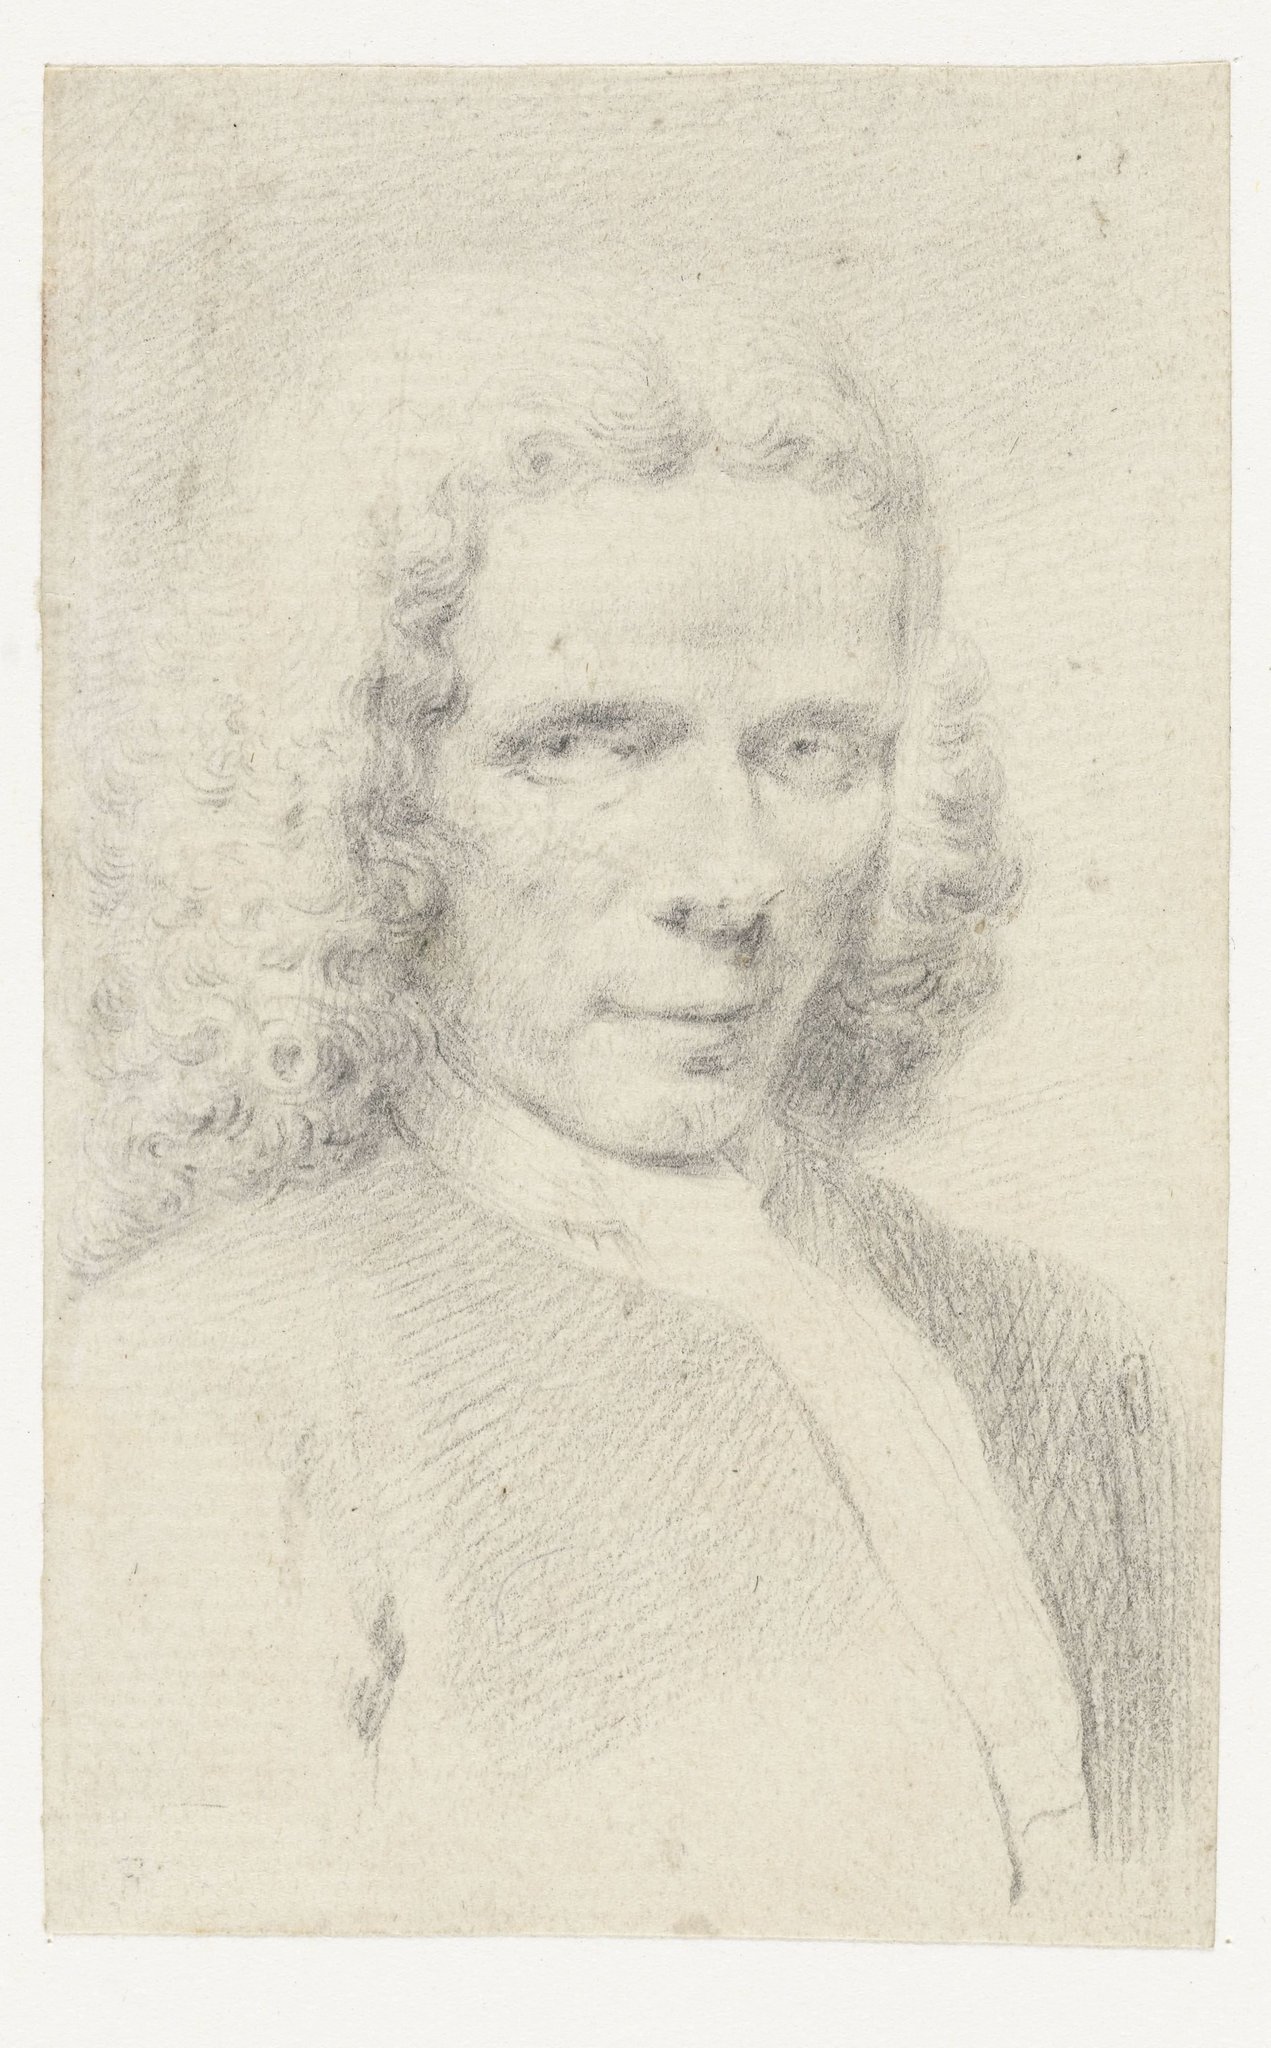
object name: drawing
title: Portret van Lambert ten Kate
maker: cornelis pronk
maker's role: draughtsman, painter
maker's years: 1691-1759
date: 1701-1759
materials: paper, pencil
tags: print maker, lambert ten kate, historical persons, portrait of a writer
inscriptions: inscription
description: Portret van Lambert ten Kate (1674-1731).